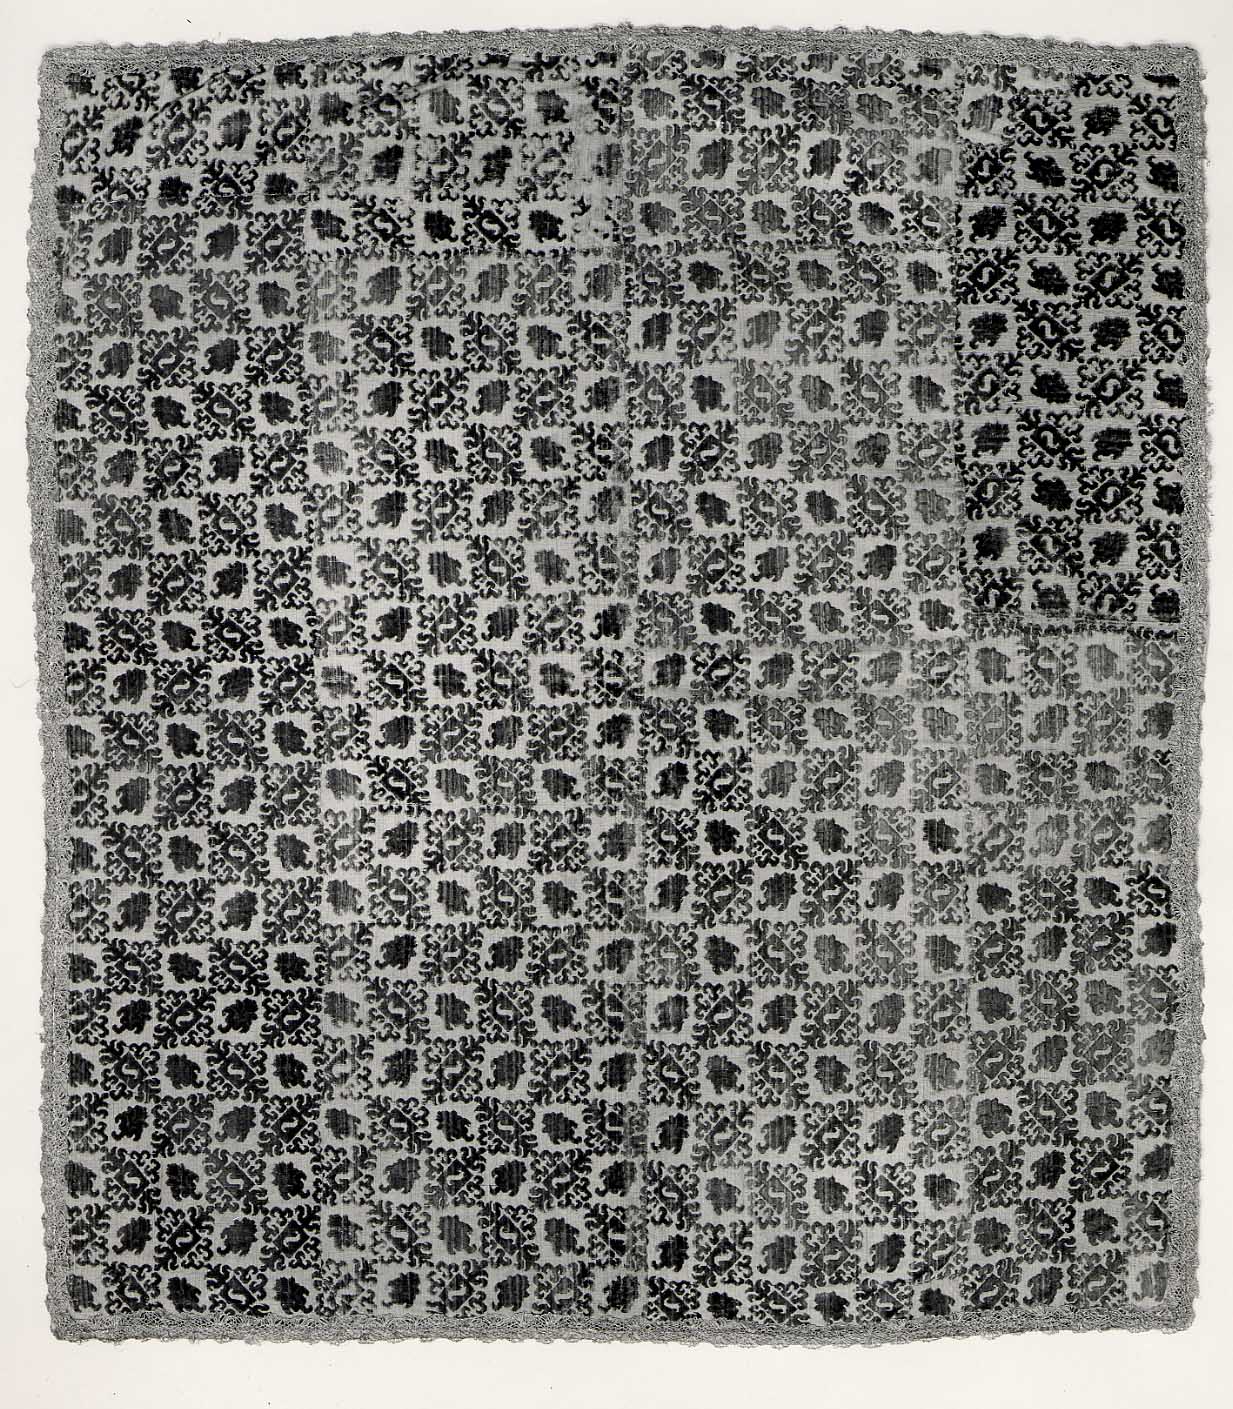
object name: textile panel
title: Panel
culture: italian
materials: cotton, metal, silk